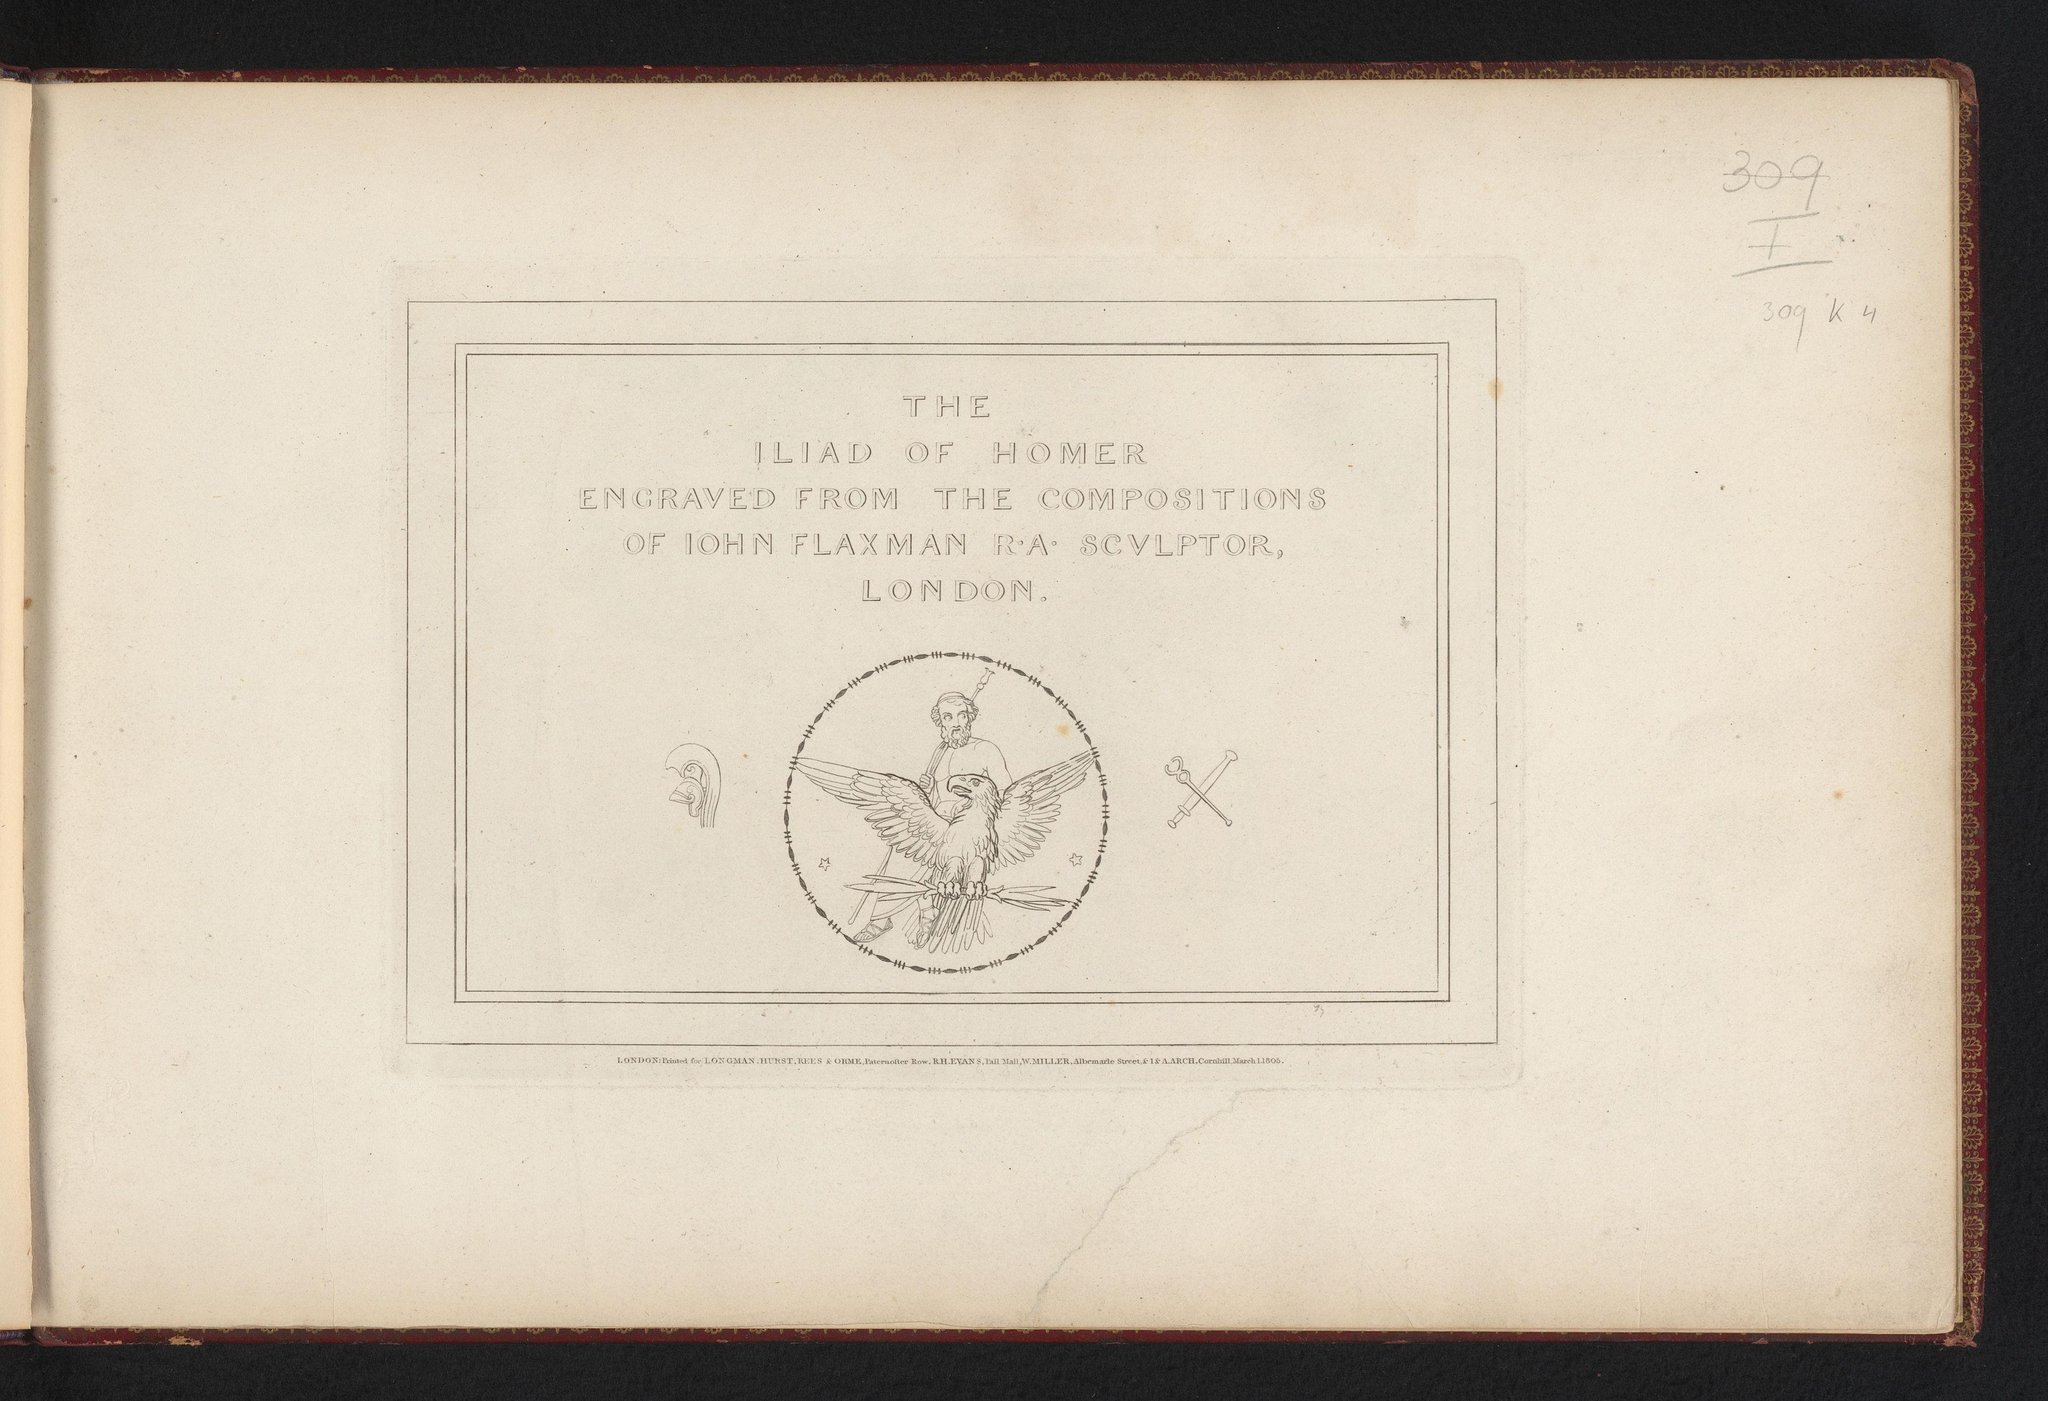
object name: titelprent, frontispice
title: The Iliad of Homer engraved from the compositions of Iohn Flaxman R..A sculptor, London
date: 1805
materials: paper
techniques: etching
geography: london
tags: homerus, predatory birds: eagle, (story of) jupiter (zeus), historical persons, portrait of homer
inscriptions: collector's mark: Lugt 2228a, collector's mark: Lugt 2760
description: Prent maakt onderdeel uit van een serie met 39 prenten over de Ilias, geschreven door Homerus.